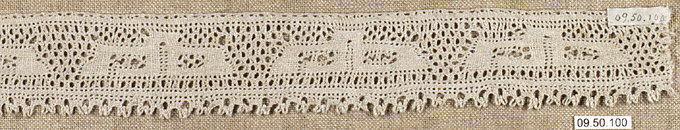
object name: strip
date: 1801-1833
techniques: lace